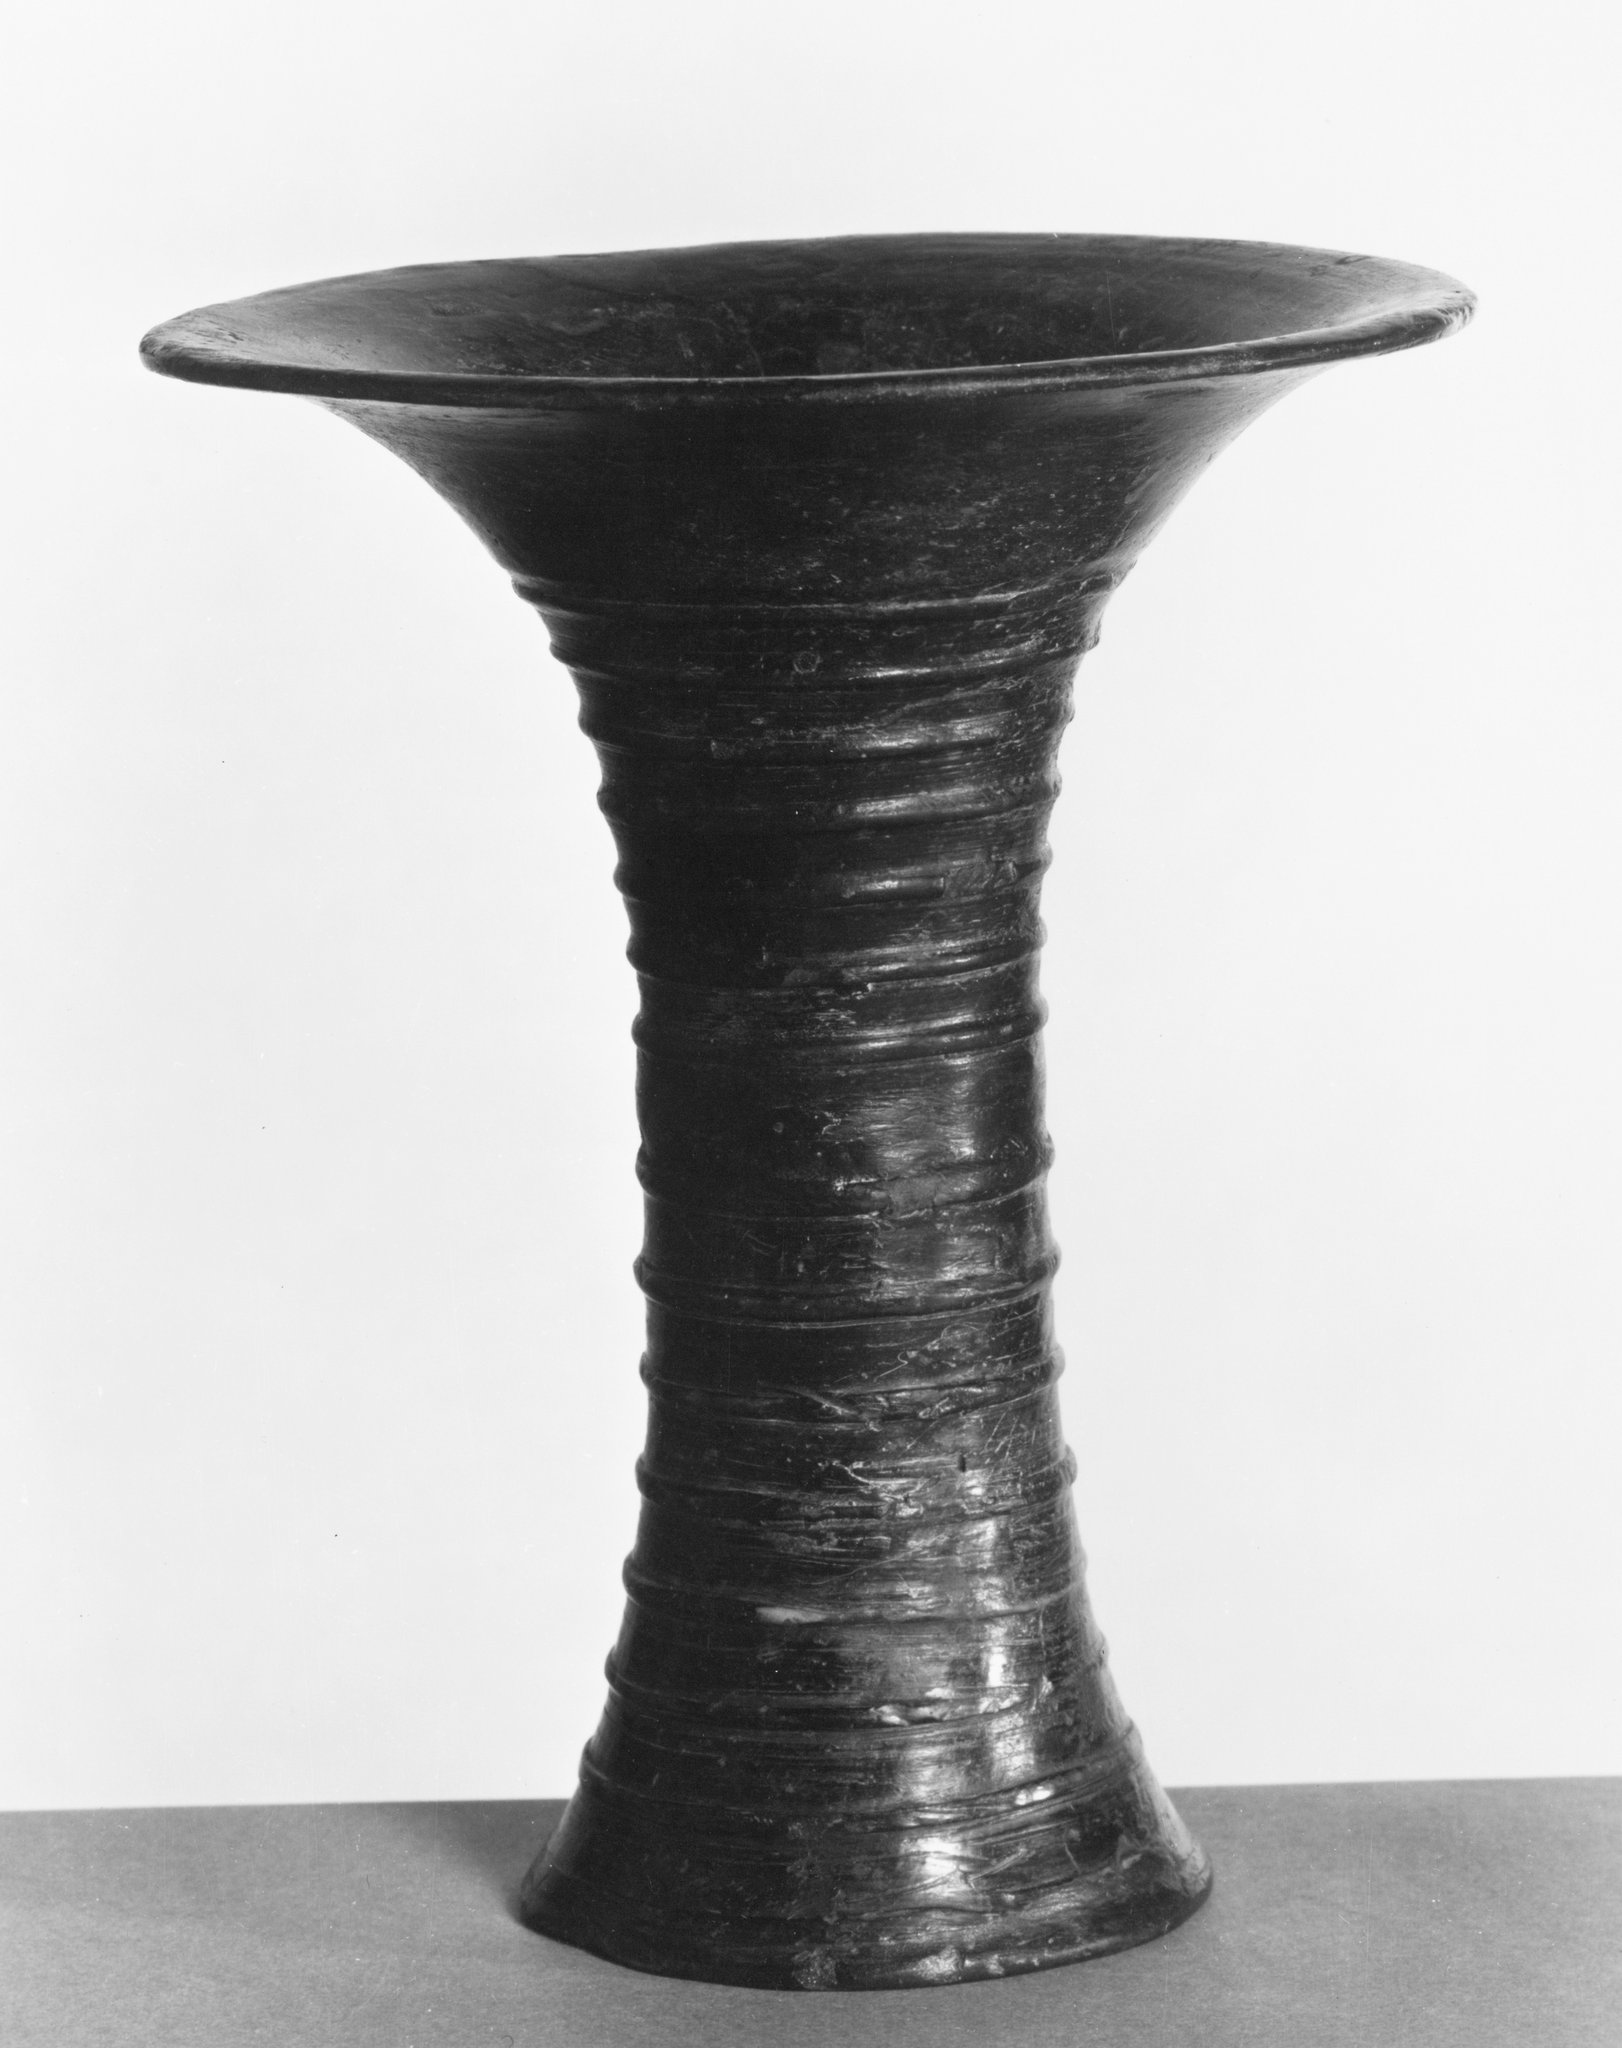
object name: beaker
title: Beaker (Hu)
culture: chinese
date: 10000-2100 BCE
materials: pottery